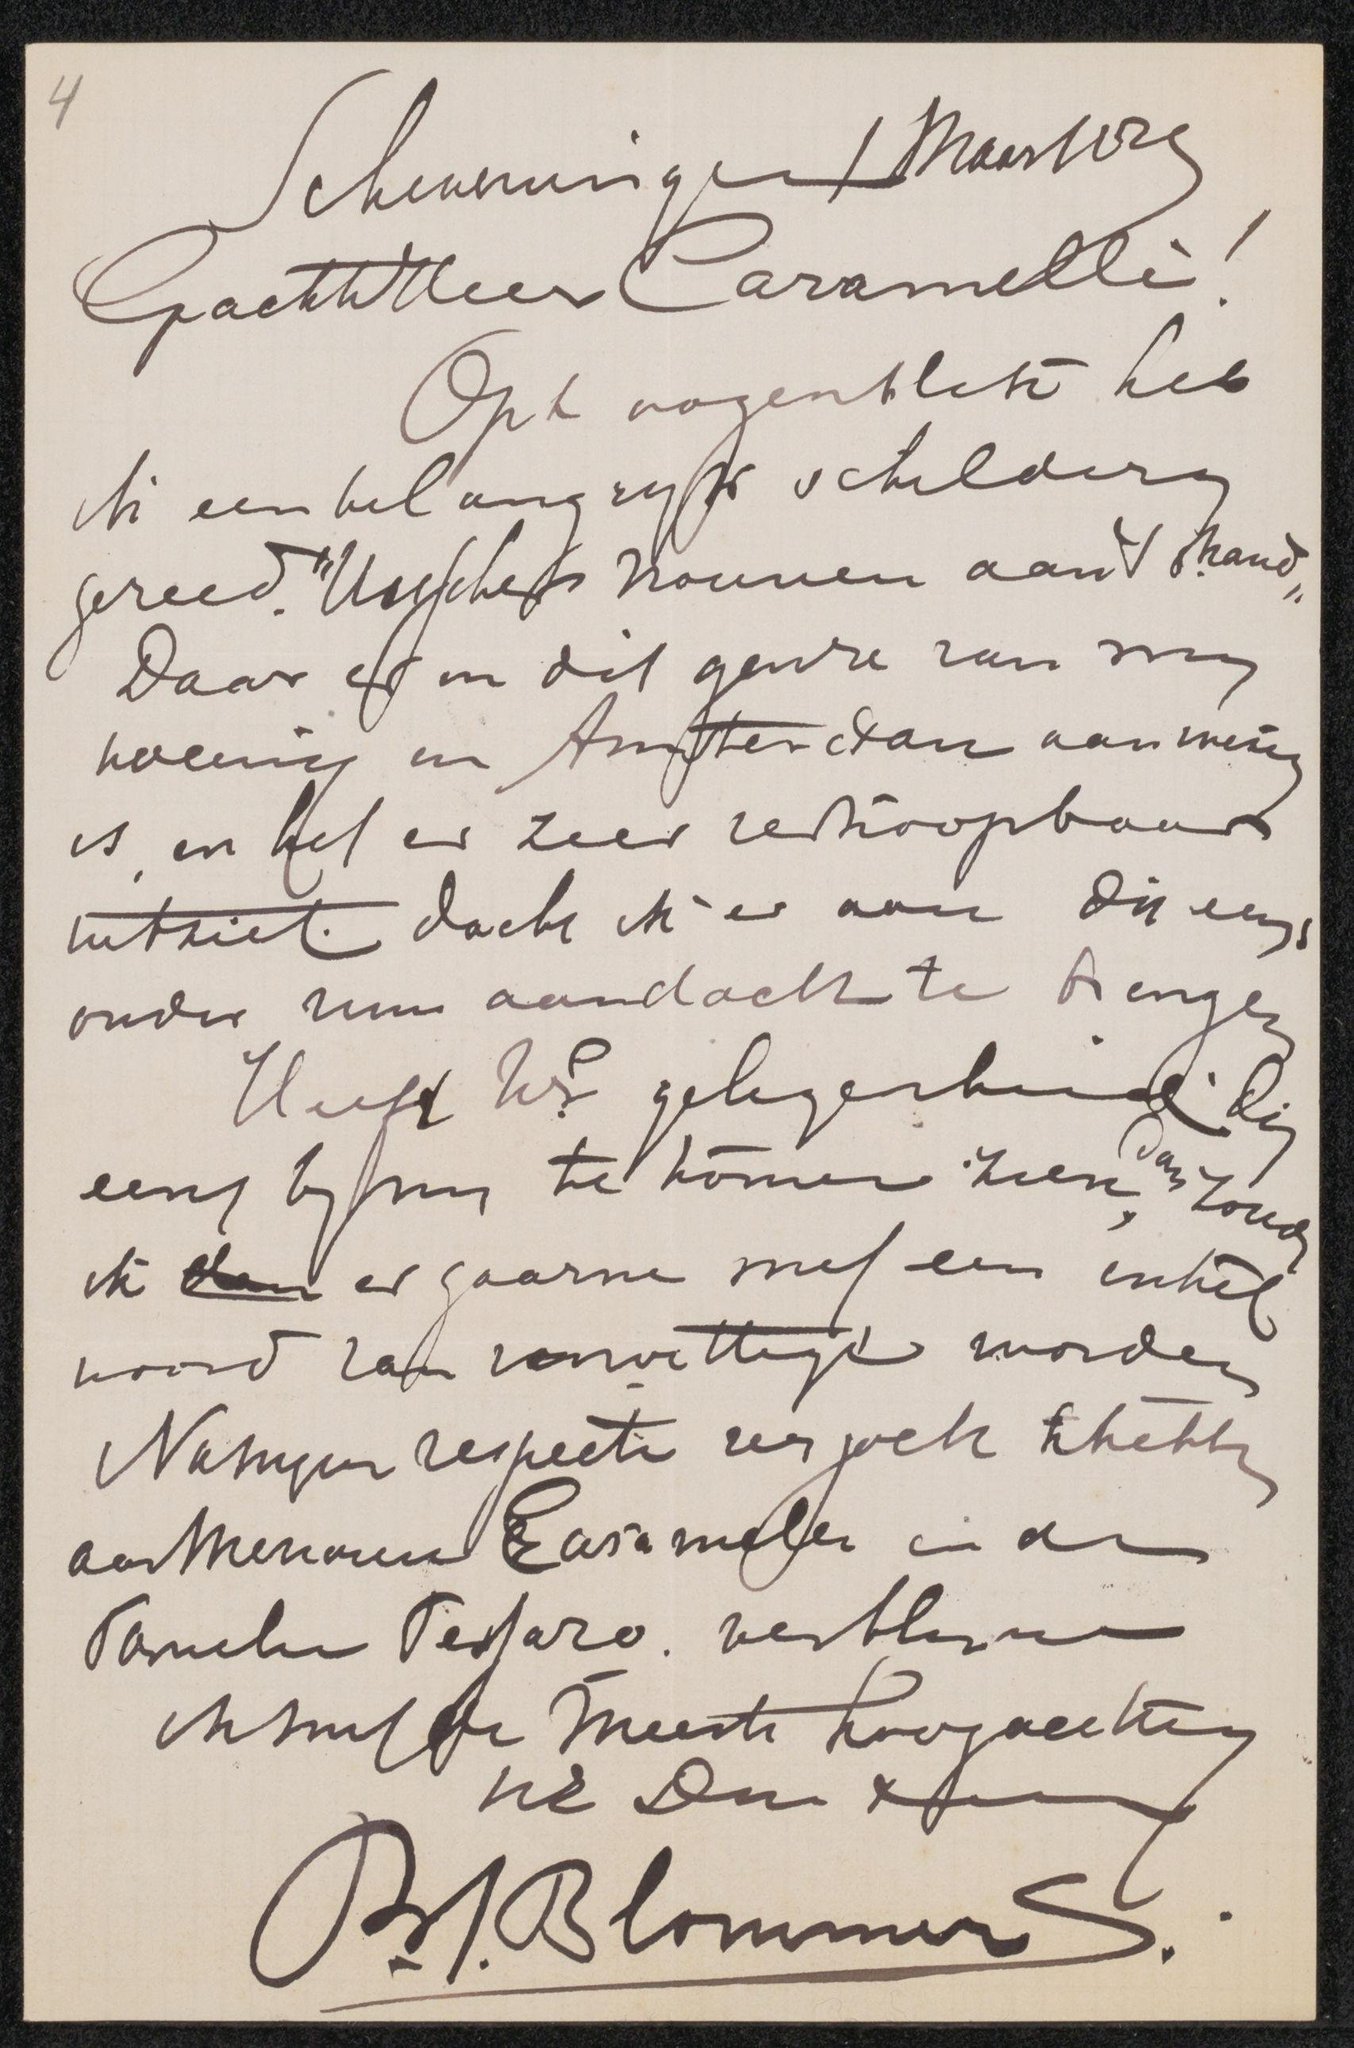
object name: letter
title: Brief aan Alberto Caramelli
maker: bernardus johannes blommers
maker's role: draughtsman, print maker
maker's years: 1845-1914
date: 1887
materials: ink, paper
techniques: pen, writing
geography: scheveningen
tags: utrecht, publisher, alberto caramelli, art trade, art shop, painting (including book-illumination, miniature-painting), amsterdam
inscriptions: collector's mark: Lugt 2233